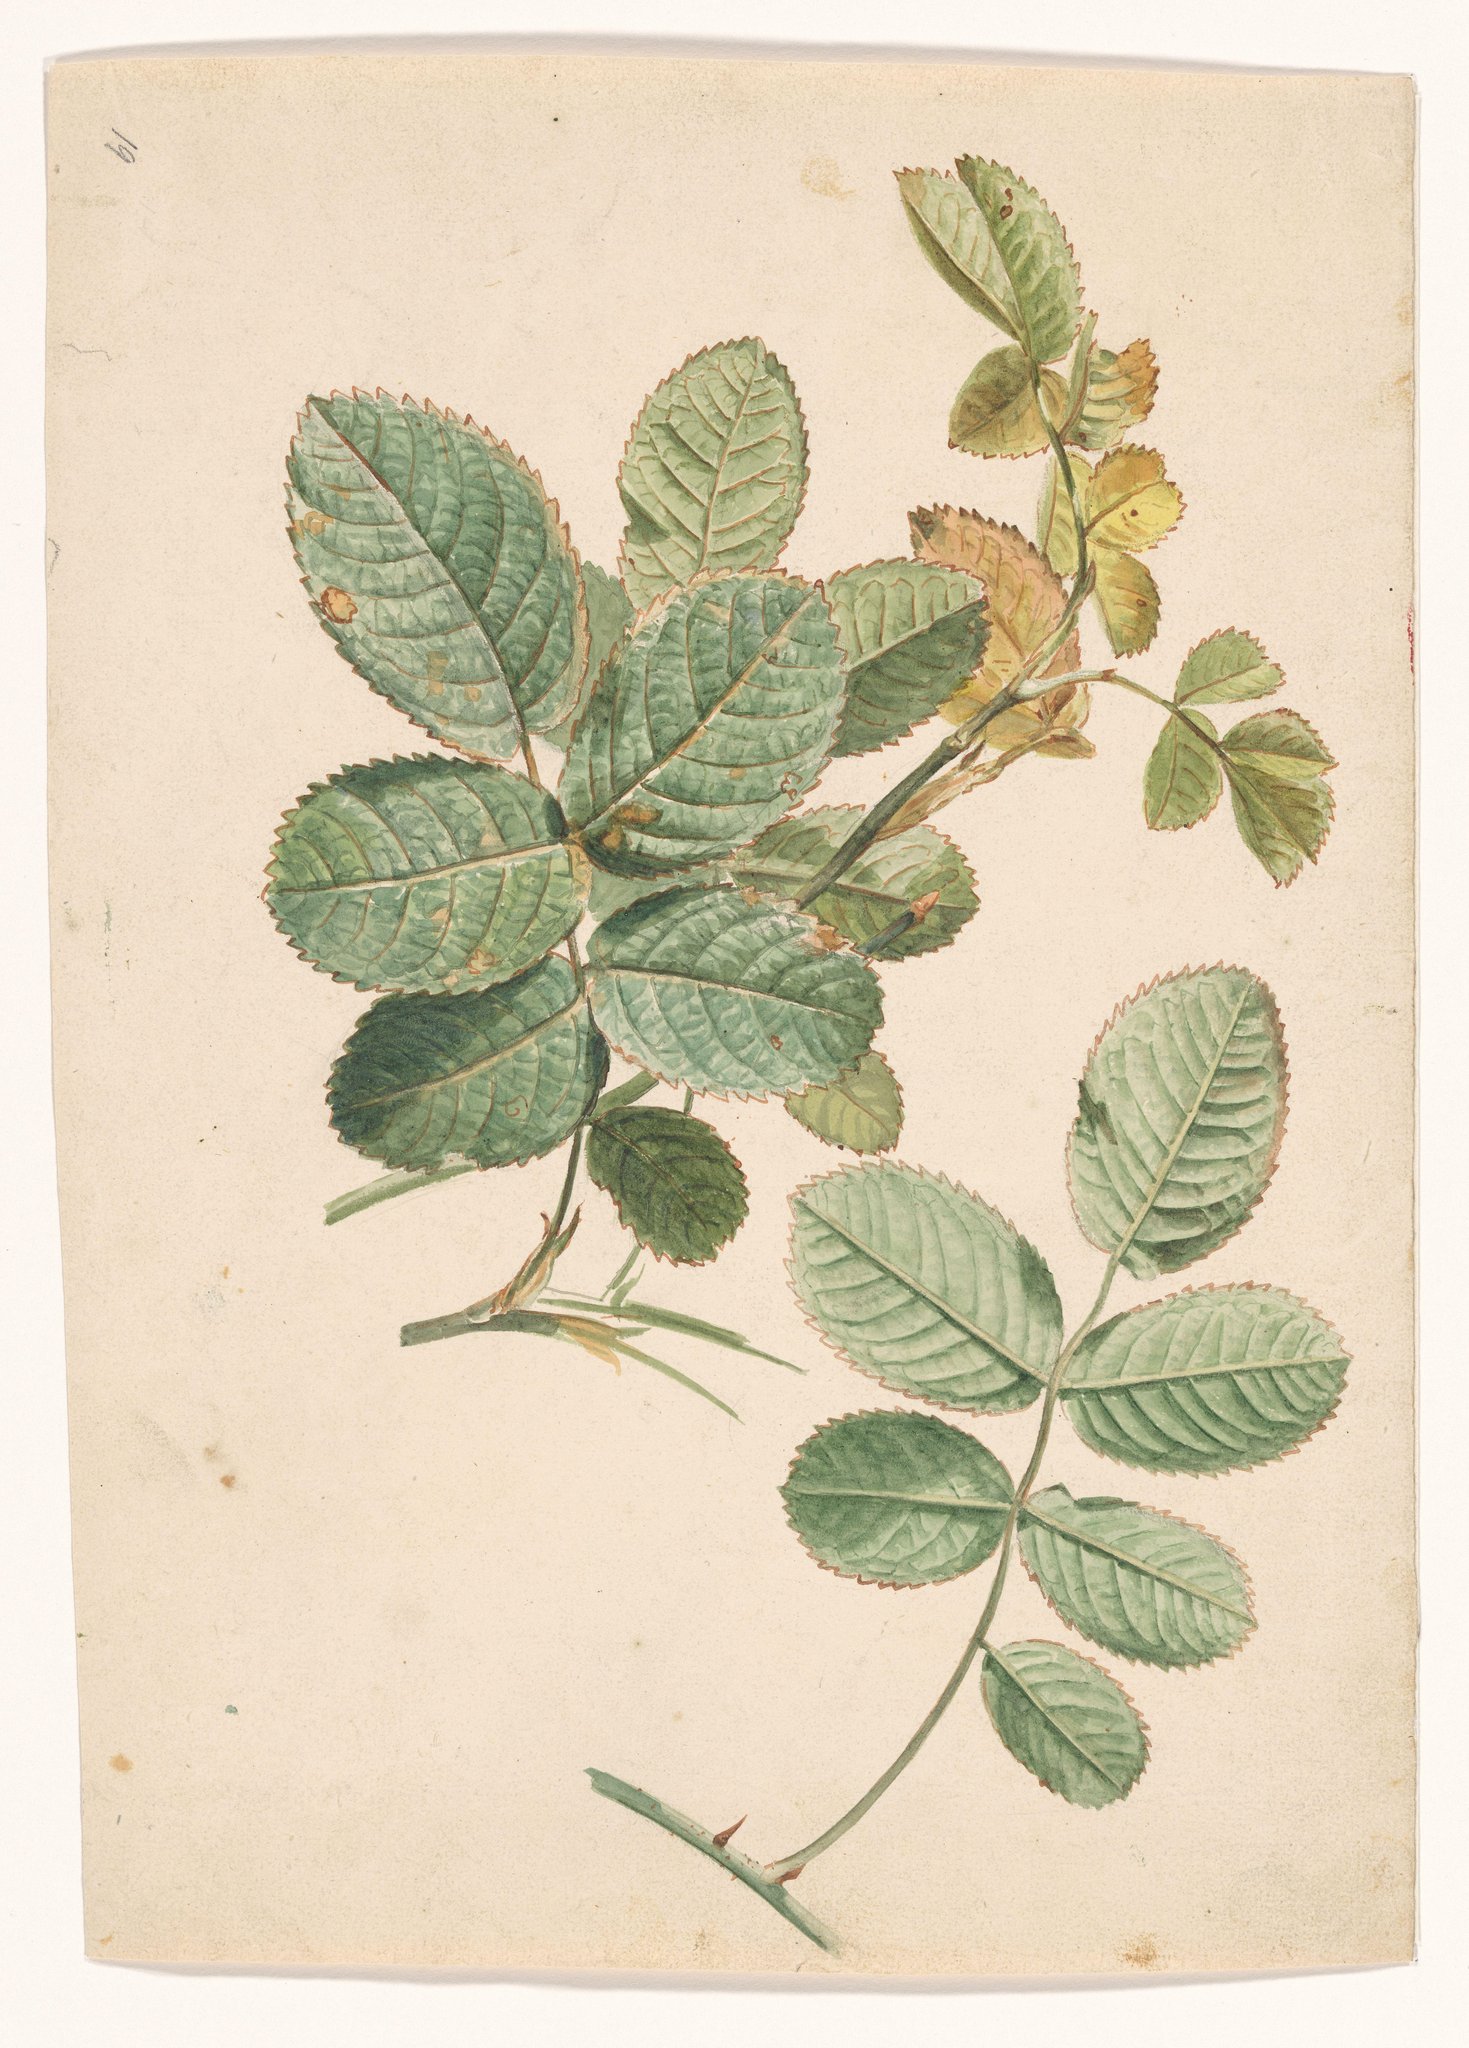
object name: drawing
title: Bladeren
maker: Anonymous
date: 1815-1830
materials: paper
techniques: drawing